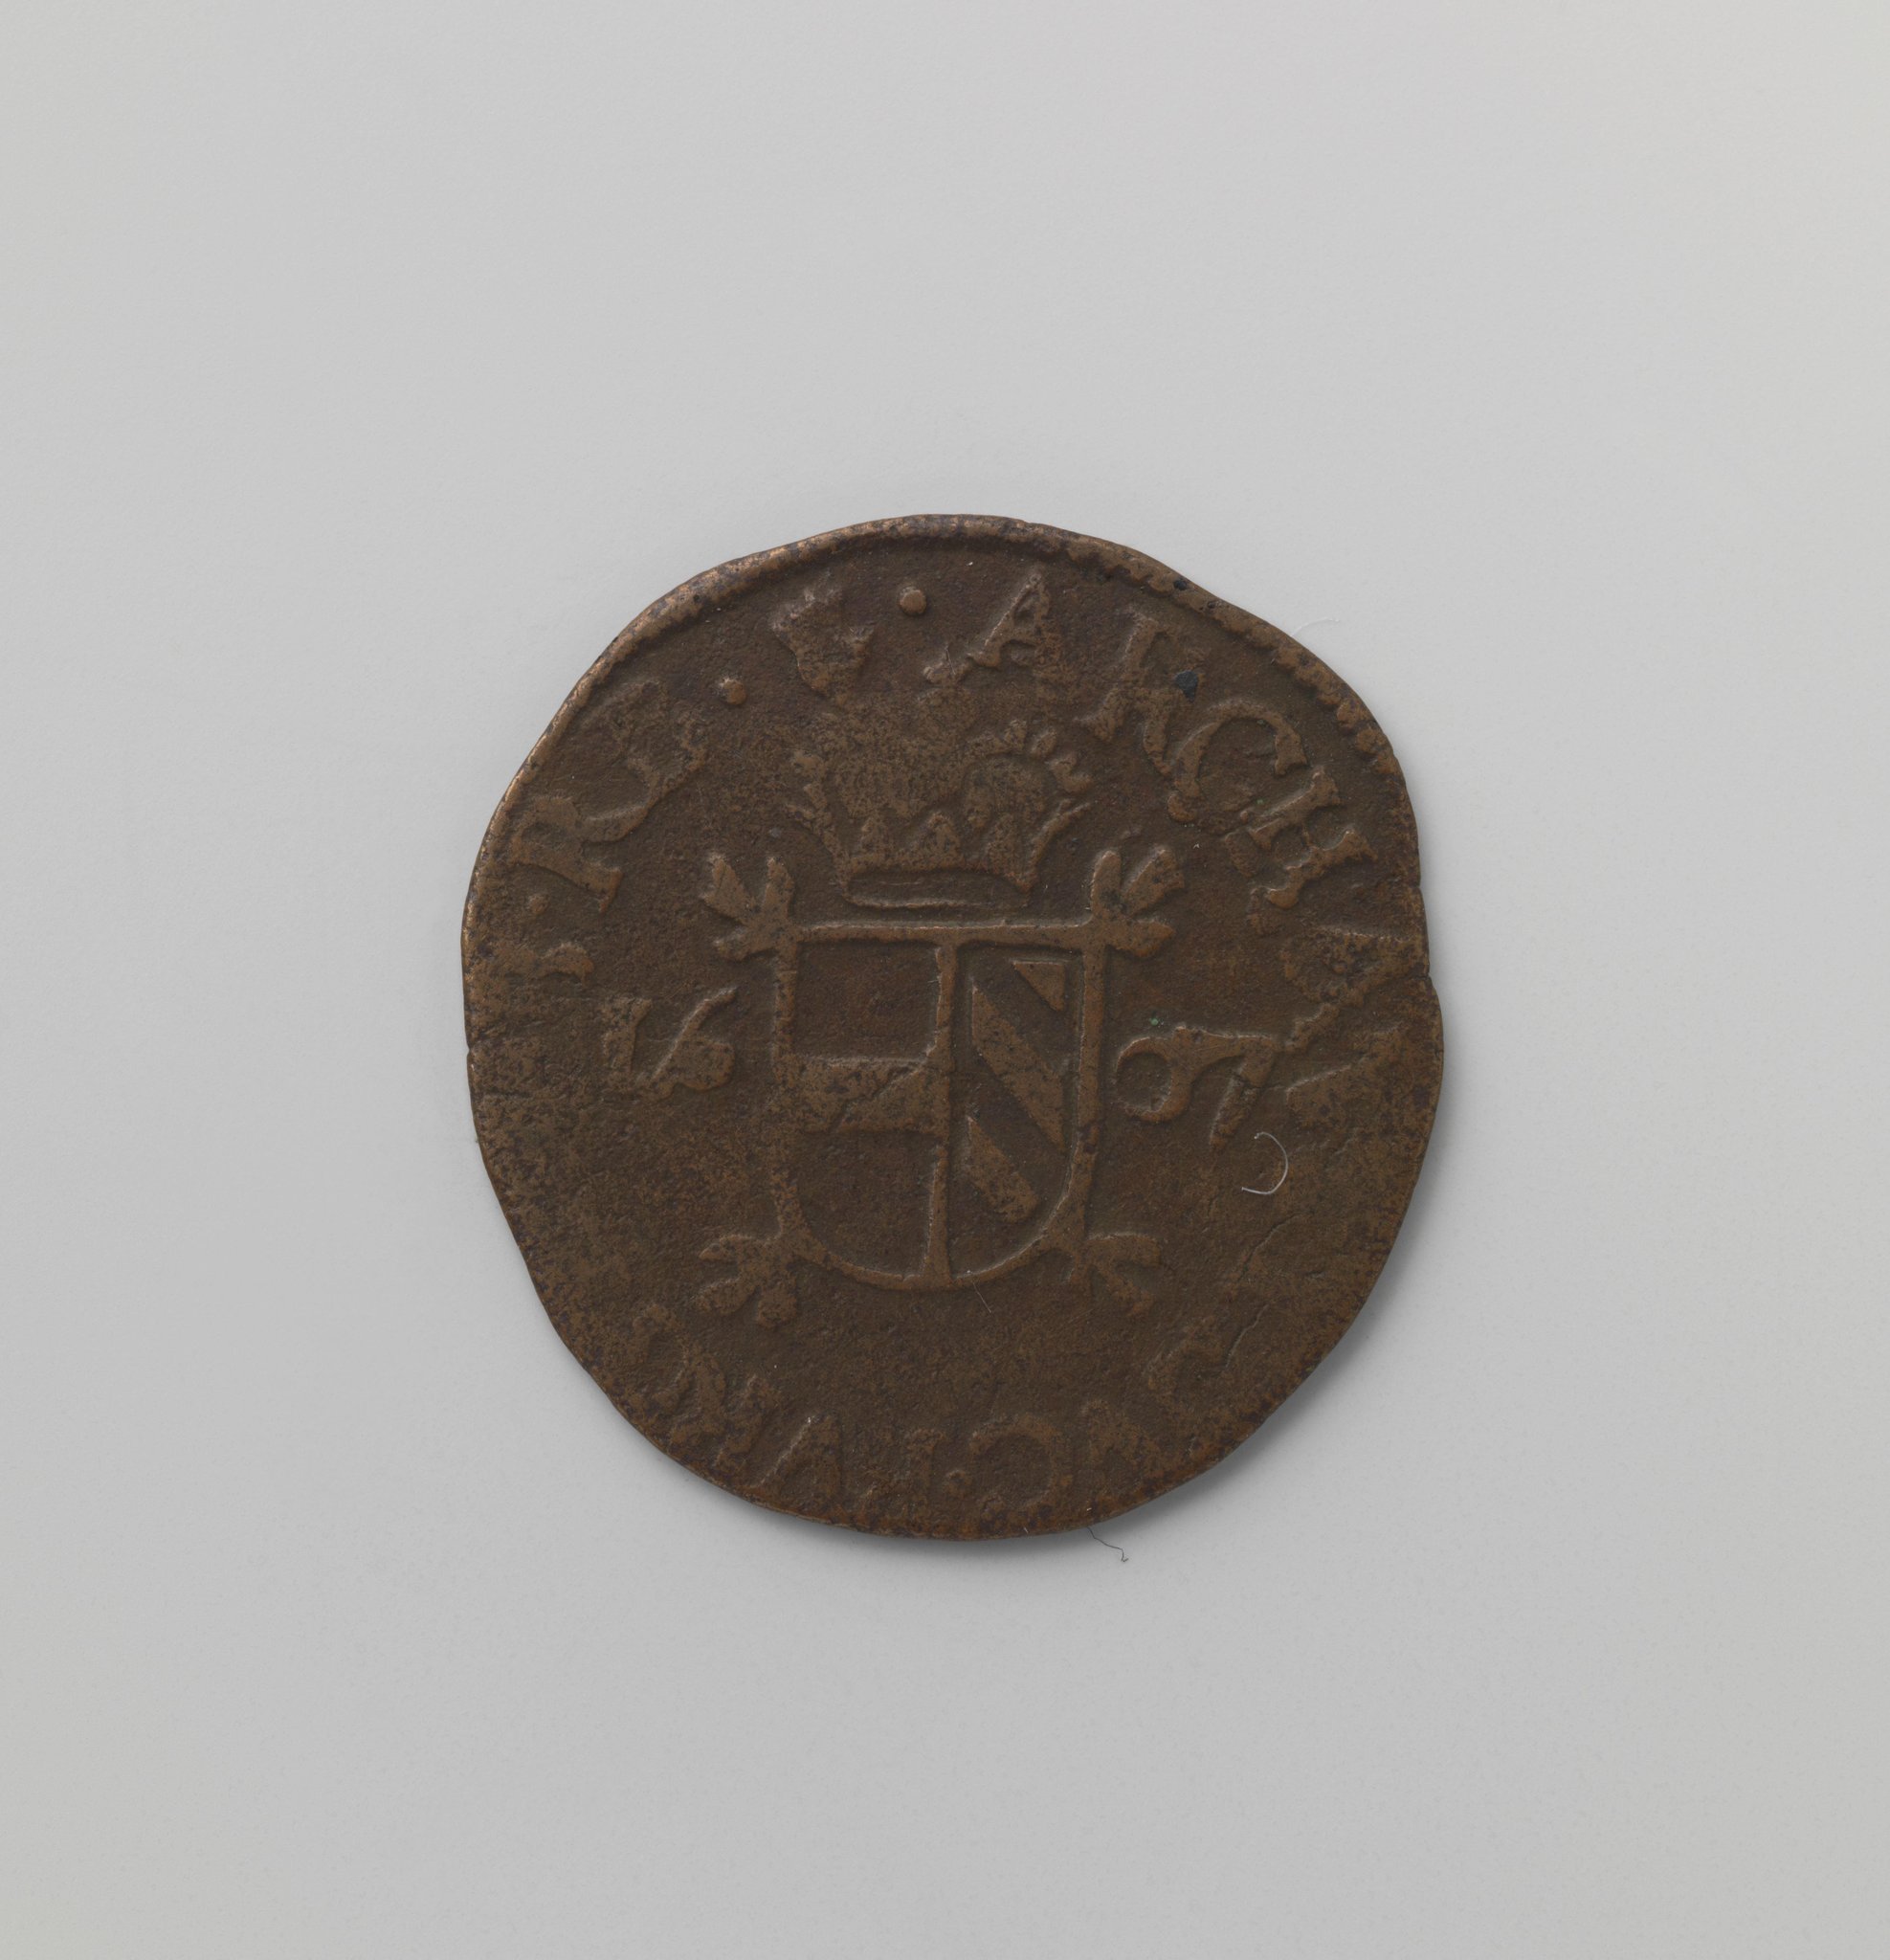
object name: coin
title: Brabant, Albert en Isabella, dubbele penning, 1607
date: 1607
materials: copper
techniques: striking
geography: antwerp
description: Koperen munt. Voorzijde: onder kroon verbonden letters A en E. Boven kroon hand. Keerzijde: tussen jaartal gekroond samengesteld wapenschild op stokkenkruis. Aan het eind van het omschrift hand.